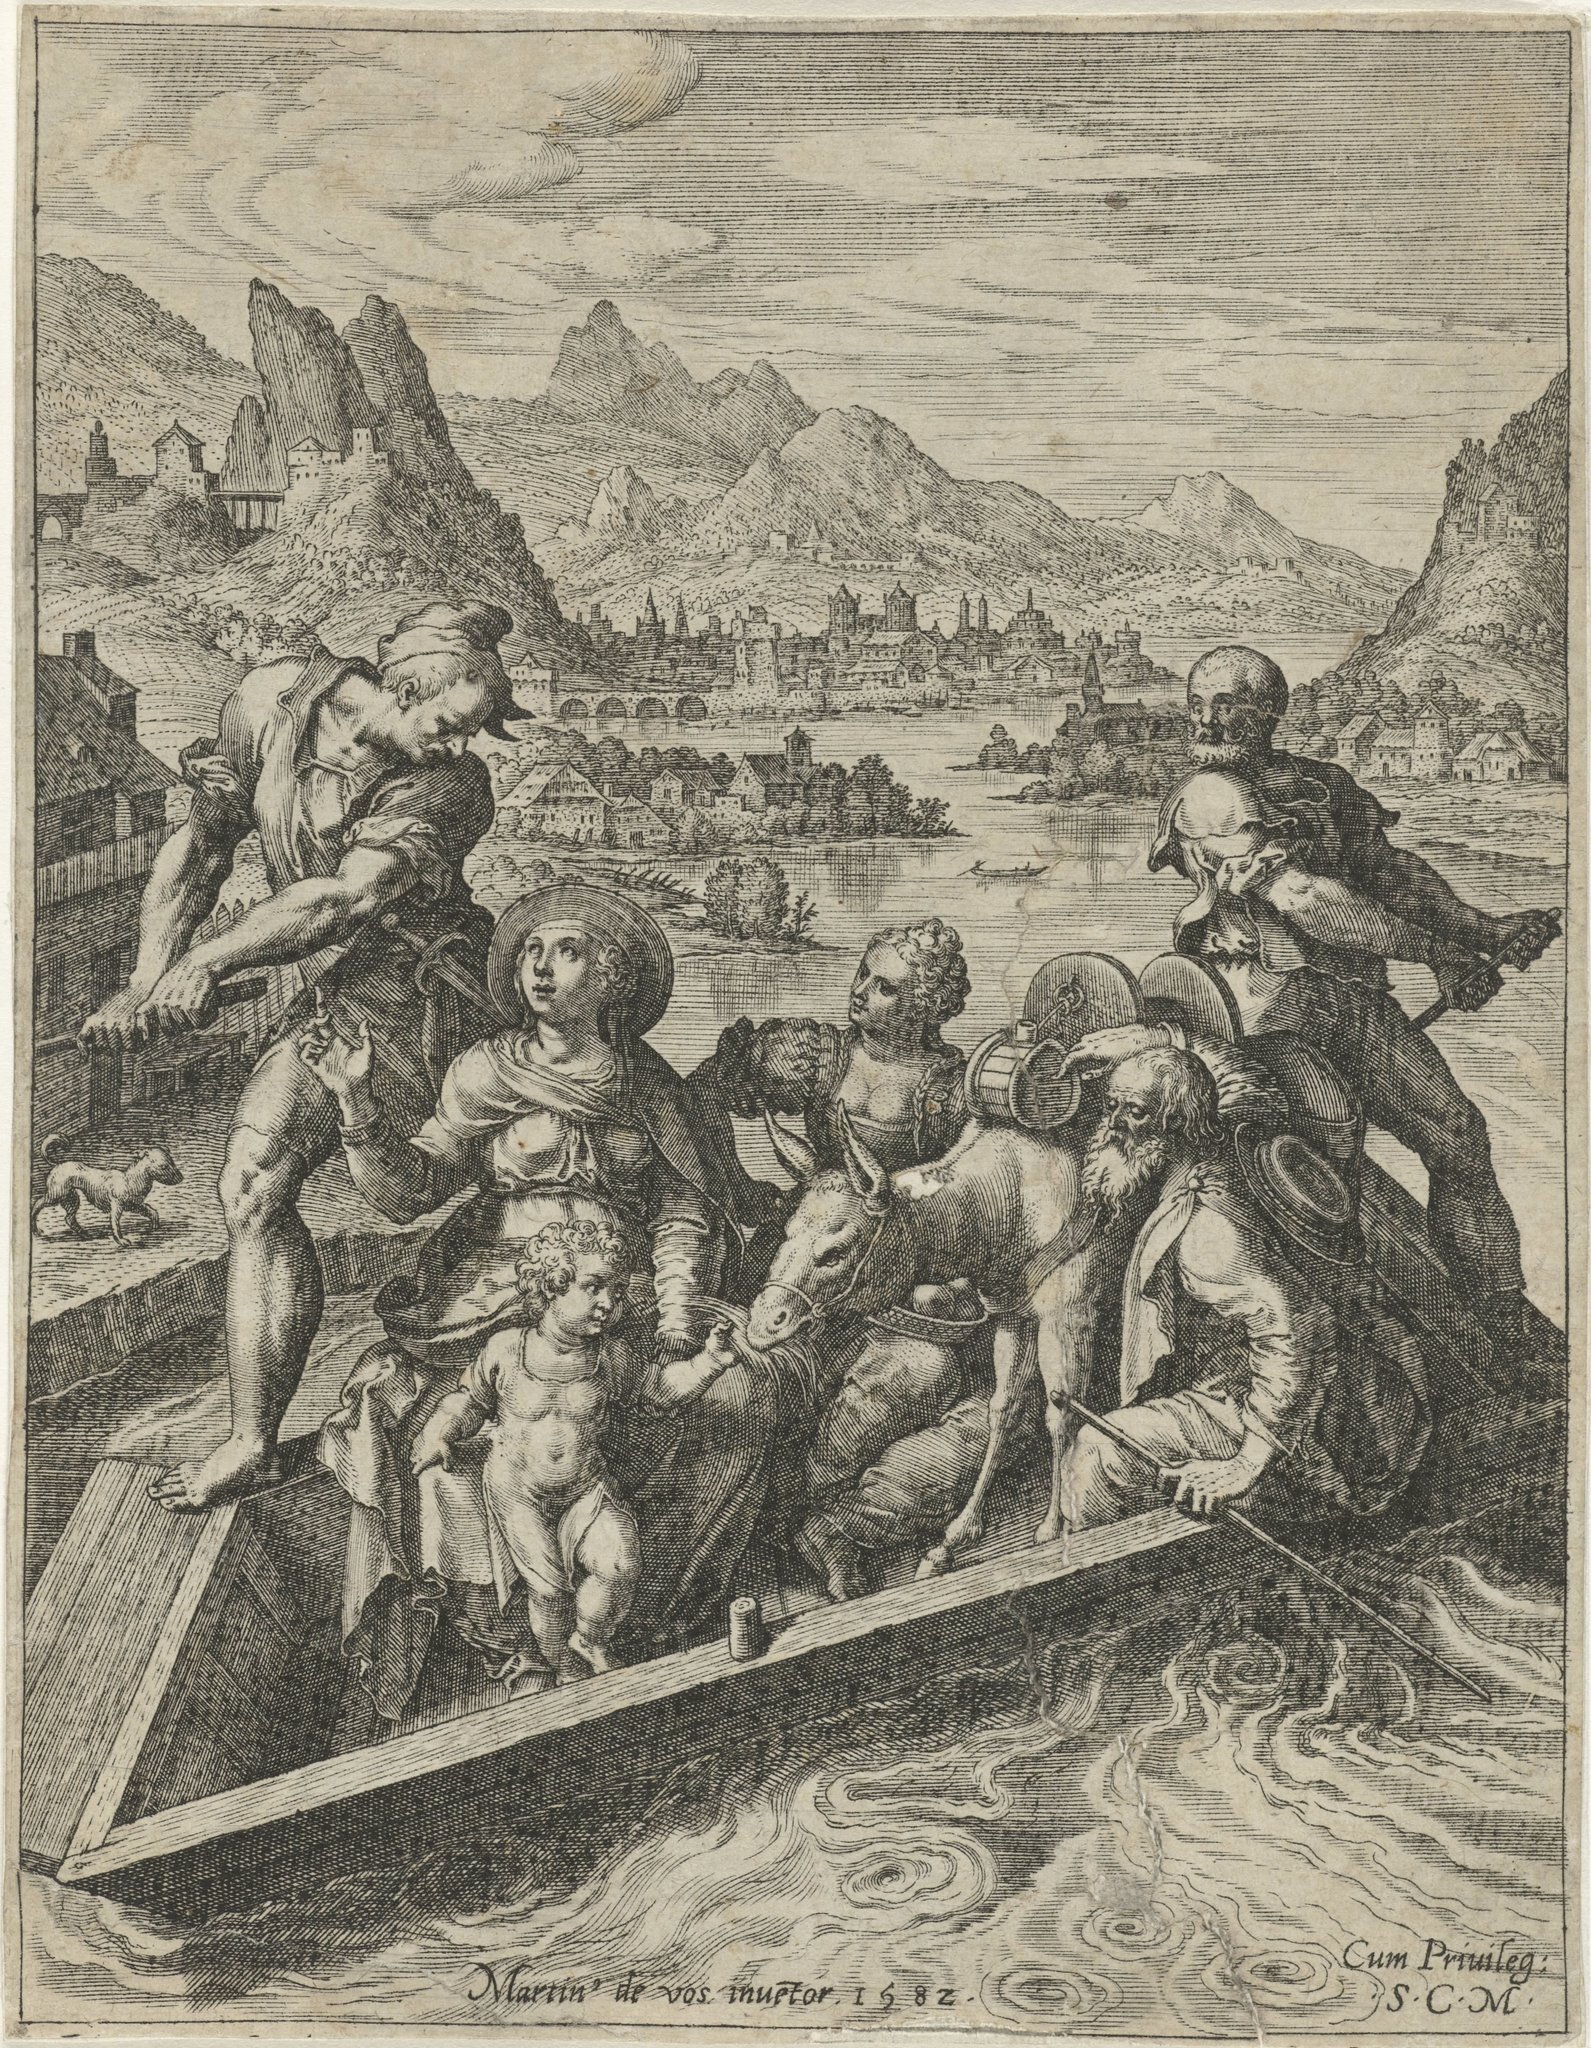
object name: print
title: Terugkeer uit Egypte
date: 1582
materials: paper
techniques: engraving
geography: cologne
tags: the holy family (and sometimes others) returning to israel, crossing a river in a boat, perhaps an angel (or sometimes charon) as ferryman ~ the flight into egypt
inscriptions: collector's mark: Lugt 240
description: Maria, Jozef en het Christuskind keren per boot terug naar Israël. Het Christuskind voedt de ezel wat stro. De prent heeft een Latijns Bijbelcitaat als onderschrift en is de elfde prent van een twaalfdelige serie over de geboorte en de eerste jaren van Christus.